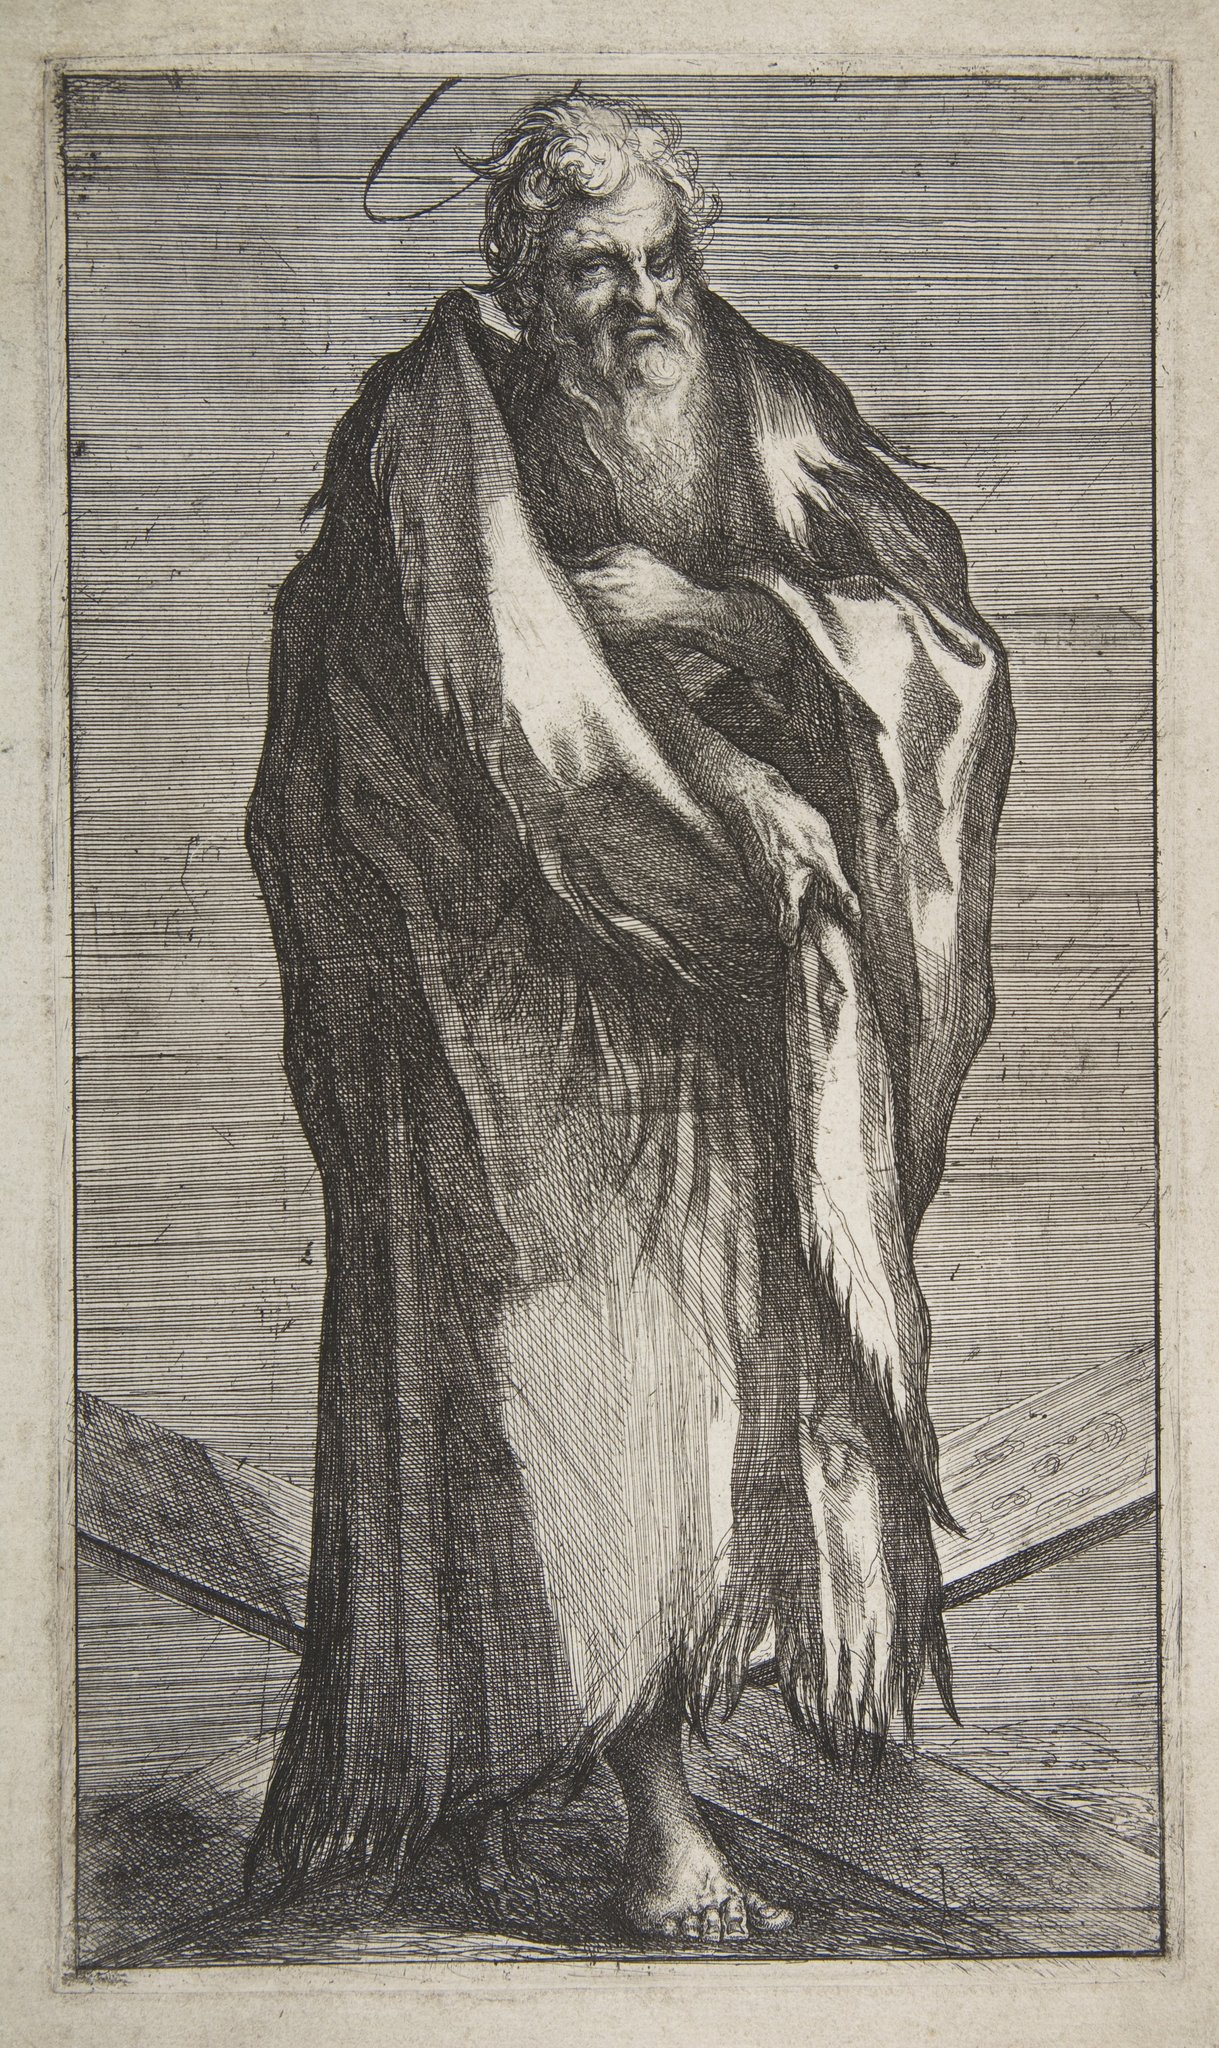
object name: print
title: Saint Andrew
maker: jacques bellange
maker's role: artist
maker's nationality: french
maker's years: 1575-1616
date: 1595-1616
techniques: etching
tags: men,saints